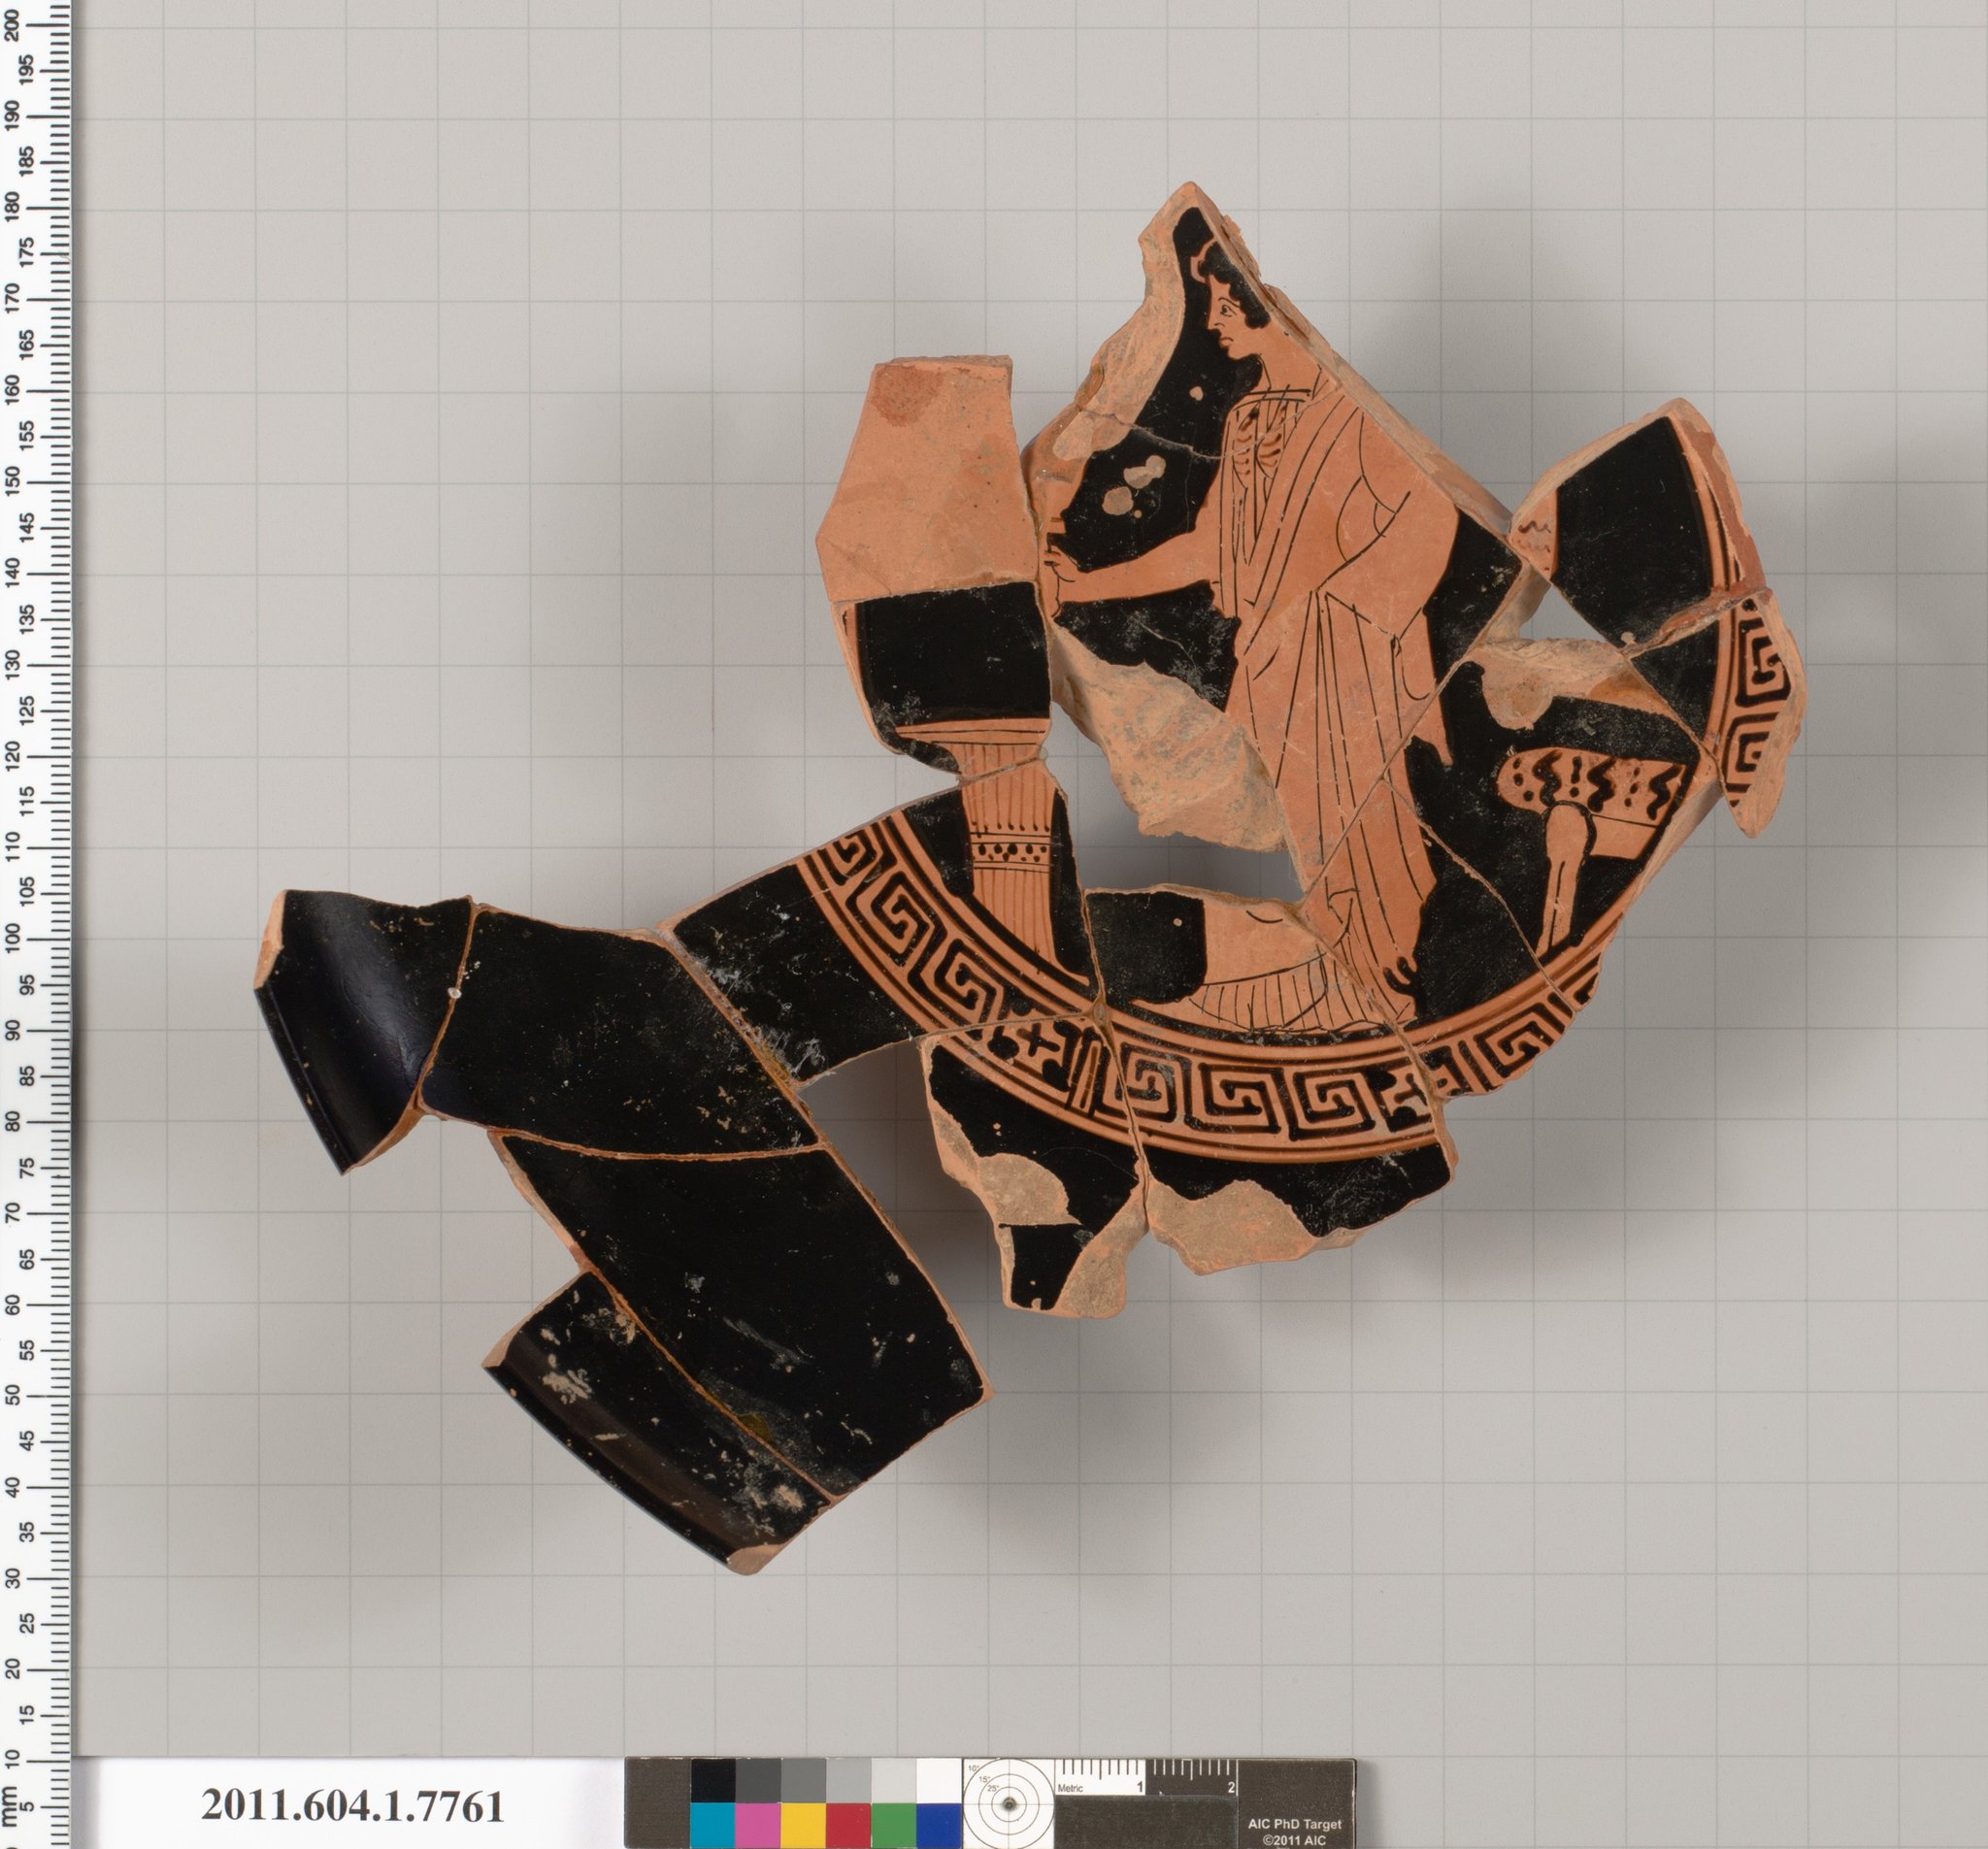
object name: kylix fragment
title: Terracotta fragment of a kylix (drinking cup)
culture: greek, attic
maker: orleans painter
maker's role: artist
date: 475-451 BCE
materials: terracotta